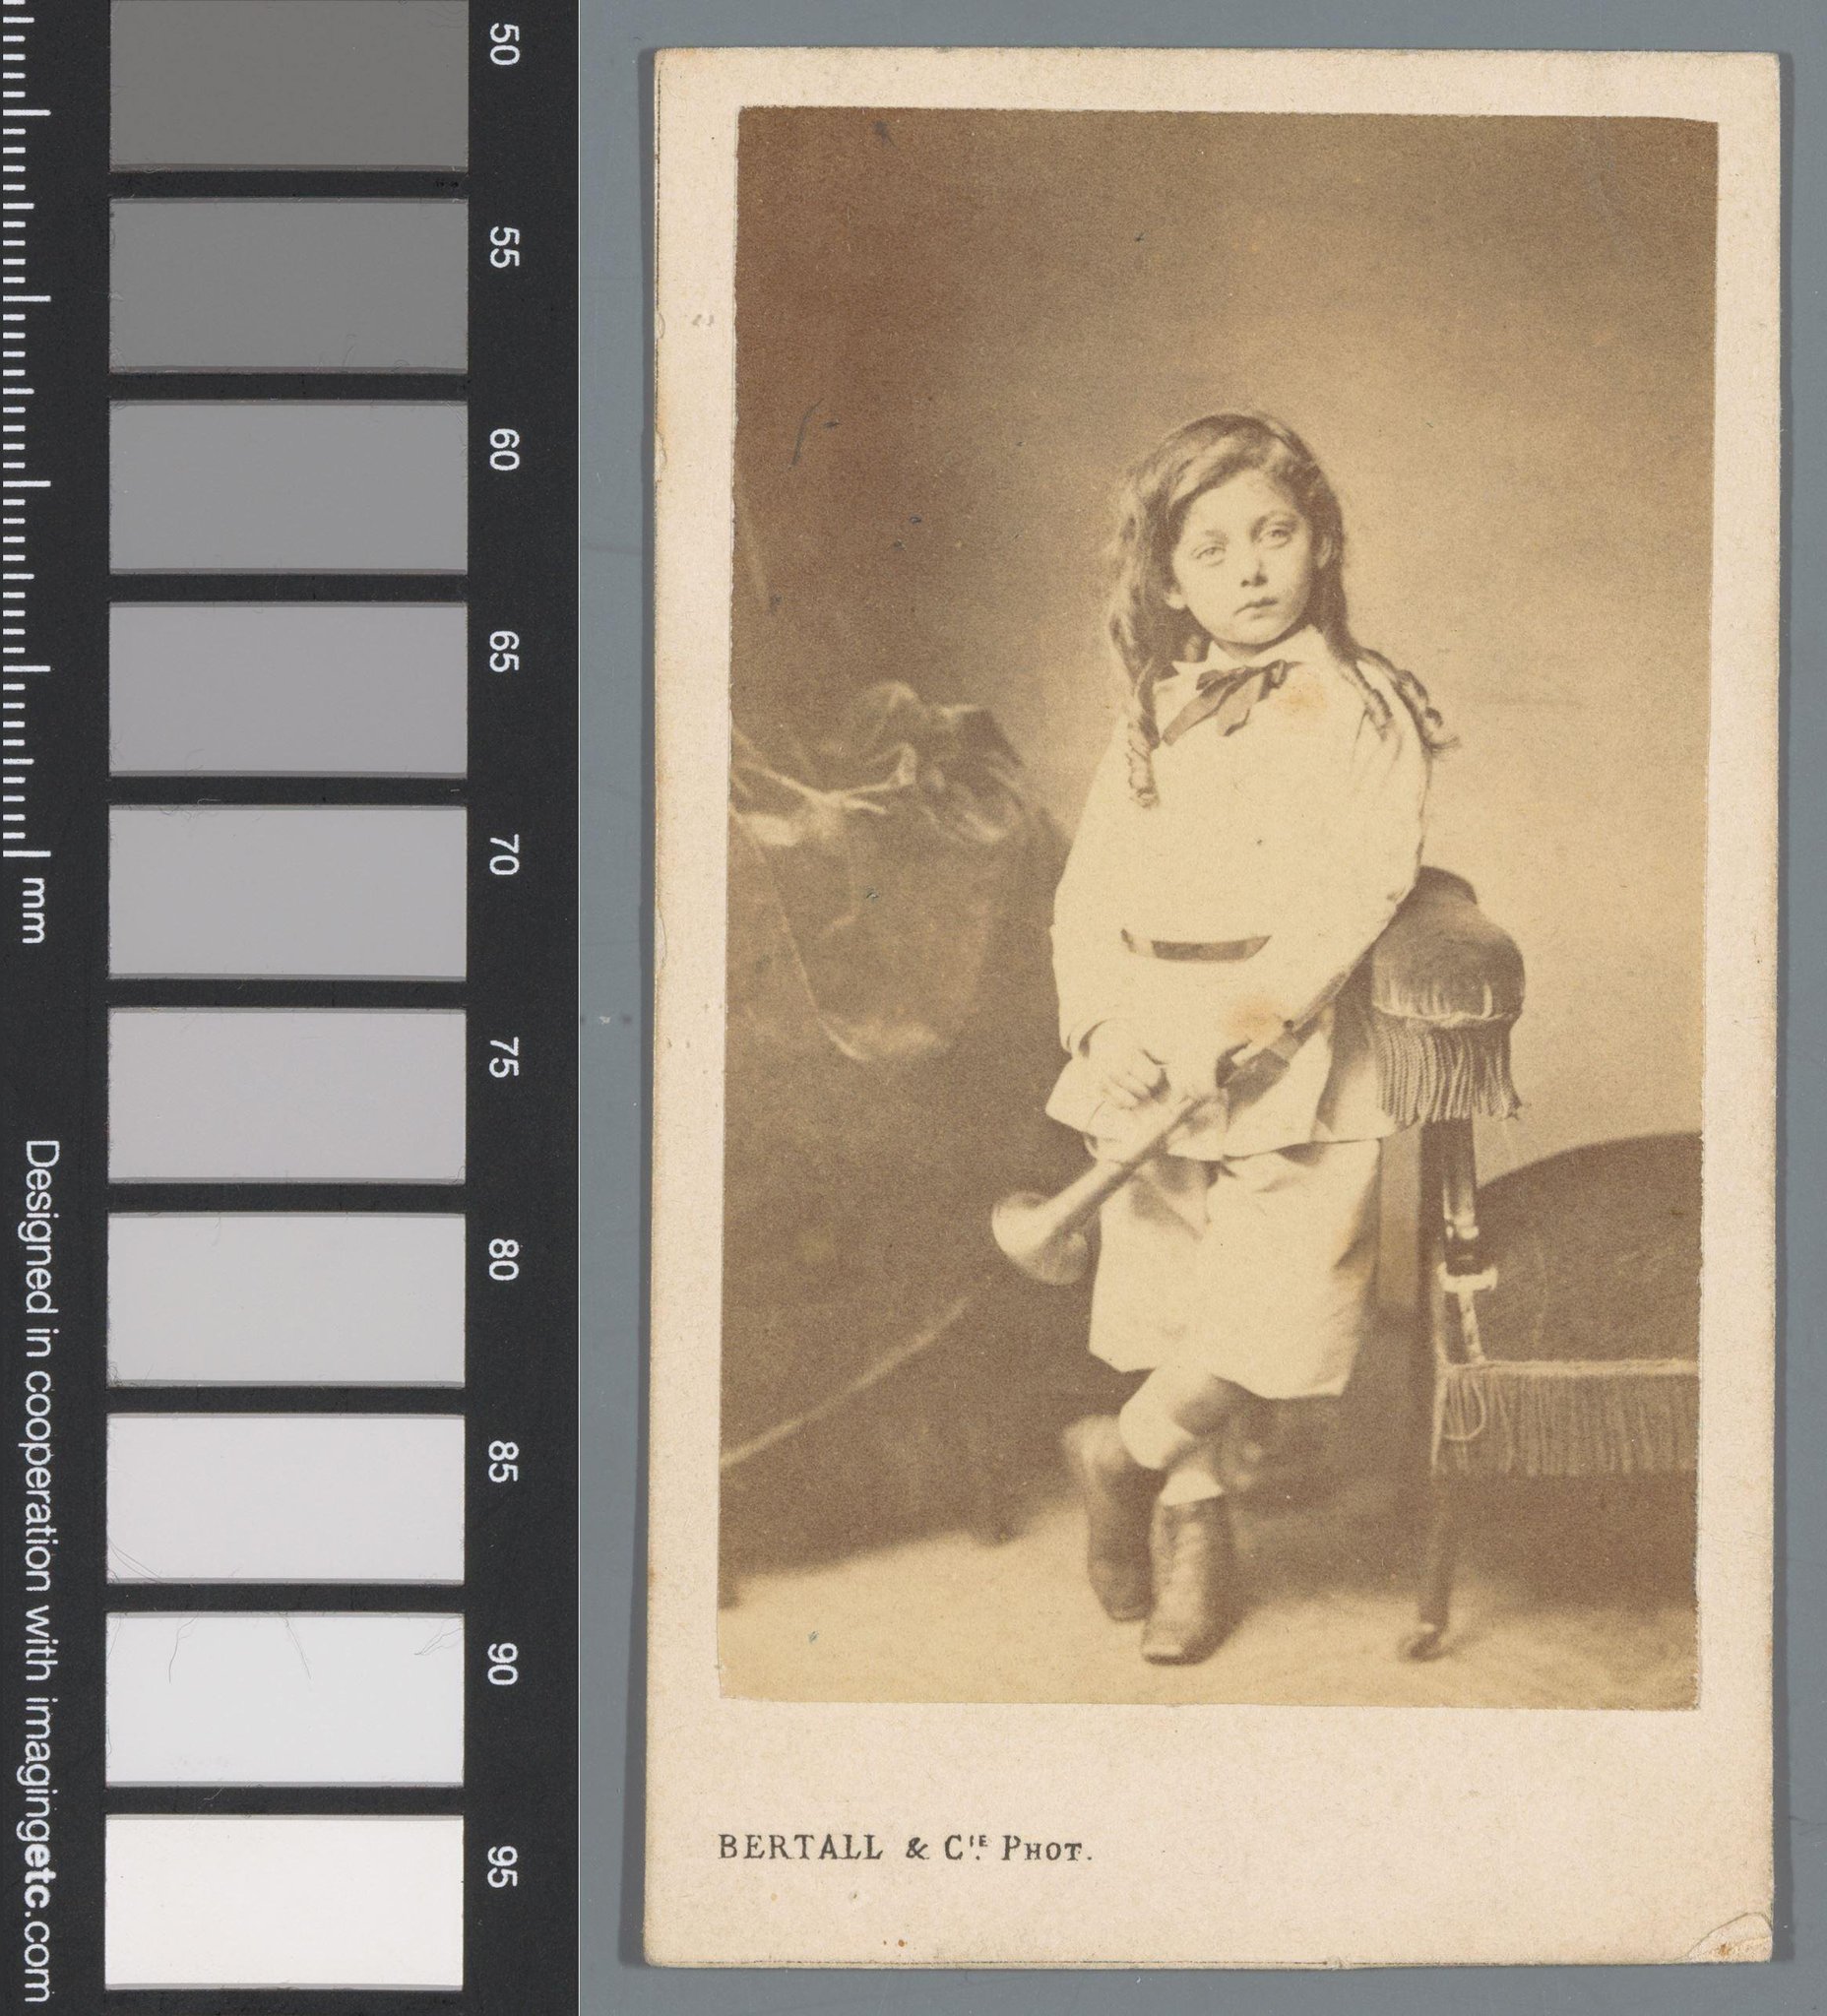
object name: photograph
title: Portret van een onbekende jongen met een trompet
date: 1866-1882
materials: cardboard, paper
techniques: albumen print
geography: paris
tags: horn, trumpet, cornet, trombone, tuba, boy (child between toddler and youth)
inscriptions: inscription: ‘PHOTOGRAPHIE/ BERTALL/ & CIE./ RUE BOISSY D'ANGLAS, 33/ Ancienne Rue de la Madeleine’